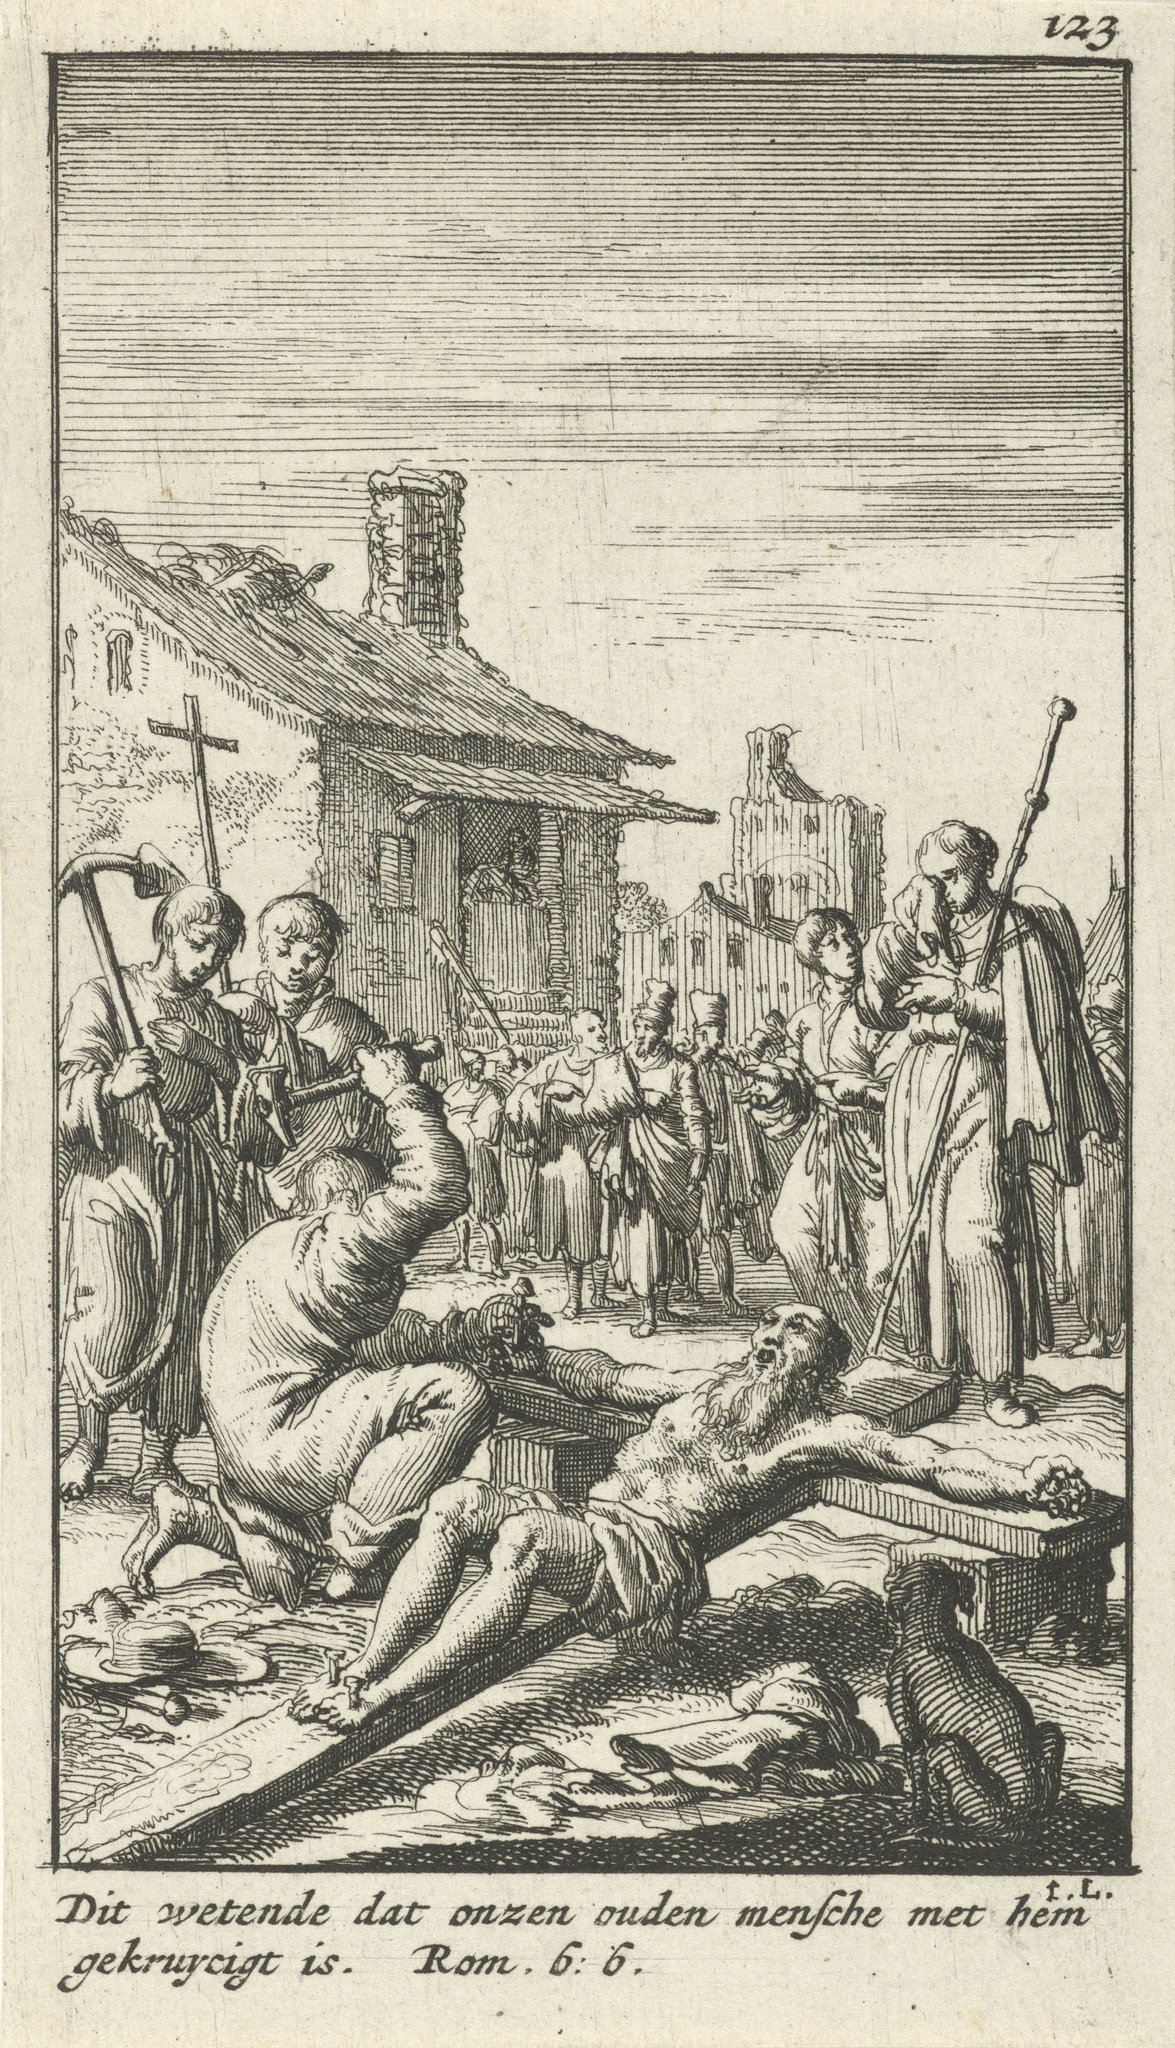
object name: book illustration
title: Kruisiging van een bejaard man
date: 1683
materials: paper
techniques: etching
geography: amsterdam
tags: violent death by crucifixion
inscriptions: collector's mark: Lugt 240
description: Illustratie opgenomen in: Dircksz, Jacob (Oom). Een alegoris-historis verhaal van het edel en machtig koninkrĳk van Salem. Amsterdam: Jan Rieuwertsz (I), 1683.